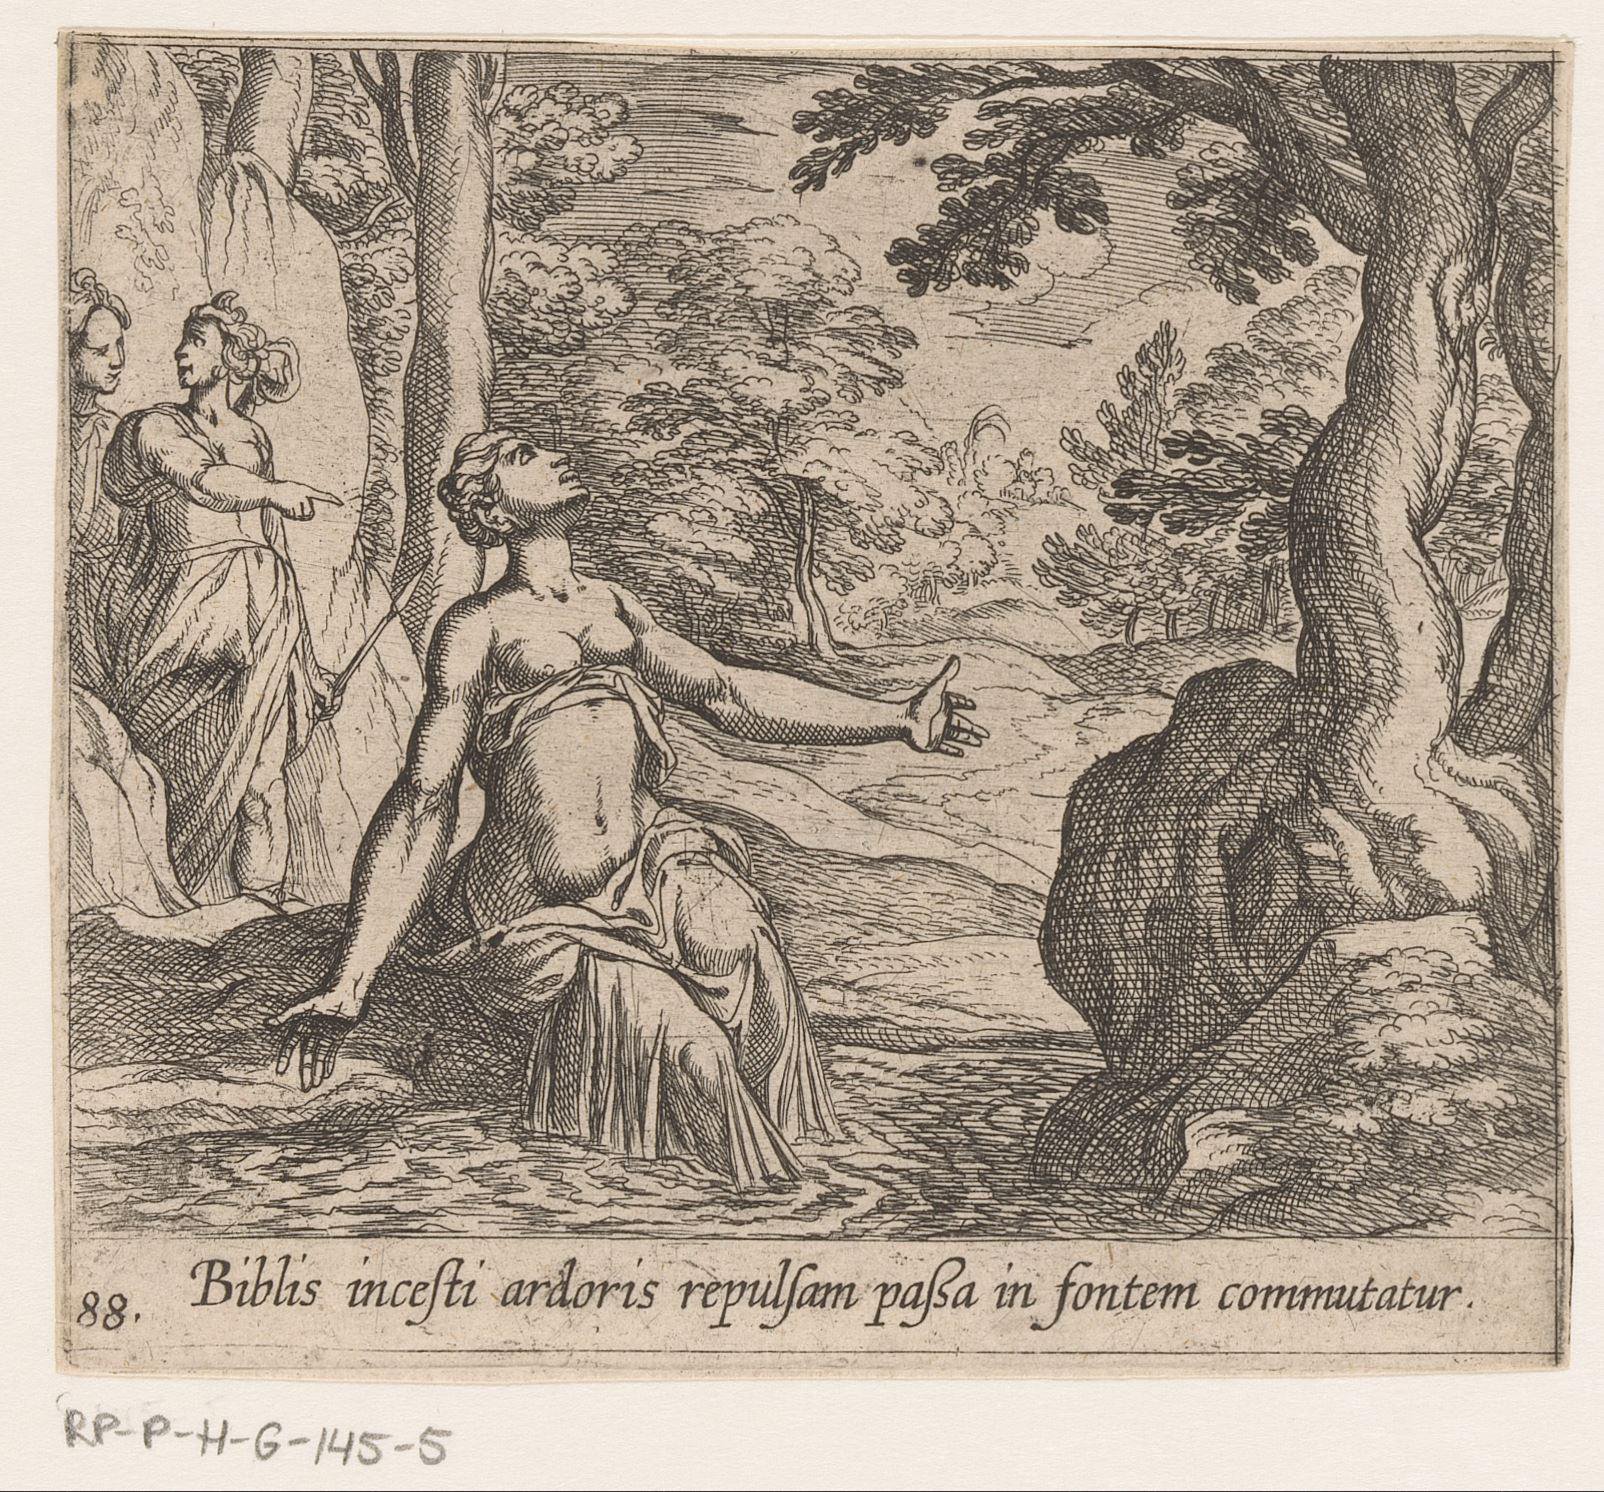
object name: print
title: Metamorphoseon sive transformationum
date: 1606-1638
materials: paper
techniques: etching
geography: italy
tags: byblis changed into a fountain: after looking for caunus everywhere, byblis at last lies down, bathed in tears, and is changed into a fountain (ovid, metamorphoses ix 663)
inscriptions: collector's mark: ‘Hinloopen’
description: Byblis was verliefd op haar broer Caunus. Toen hij verdween en zij hem niet kon vinden baadde Byblis in tranen. Ze verandert in een beek. Titel in het Latijn in ondermarge.